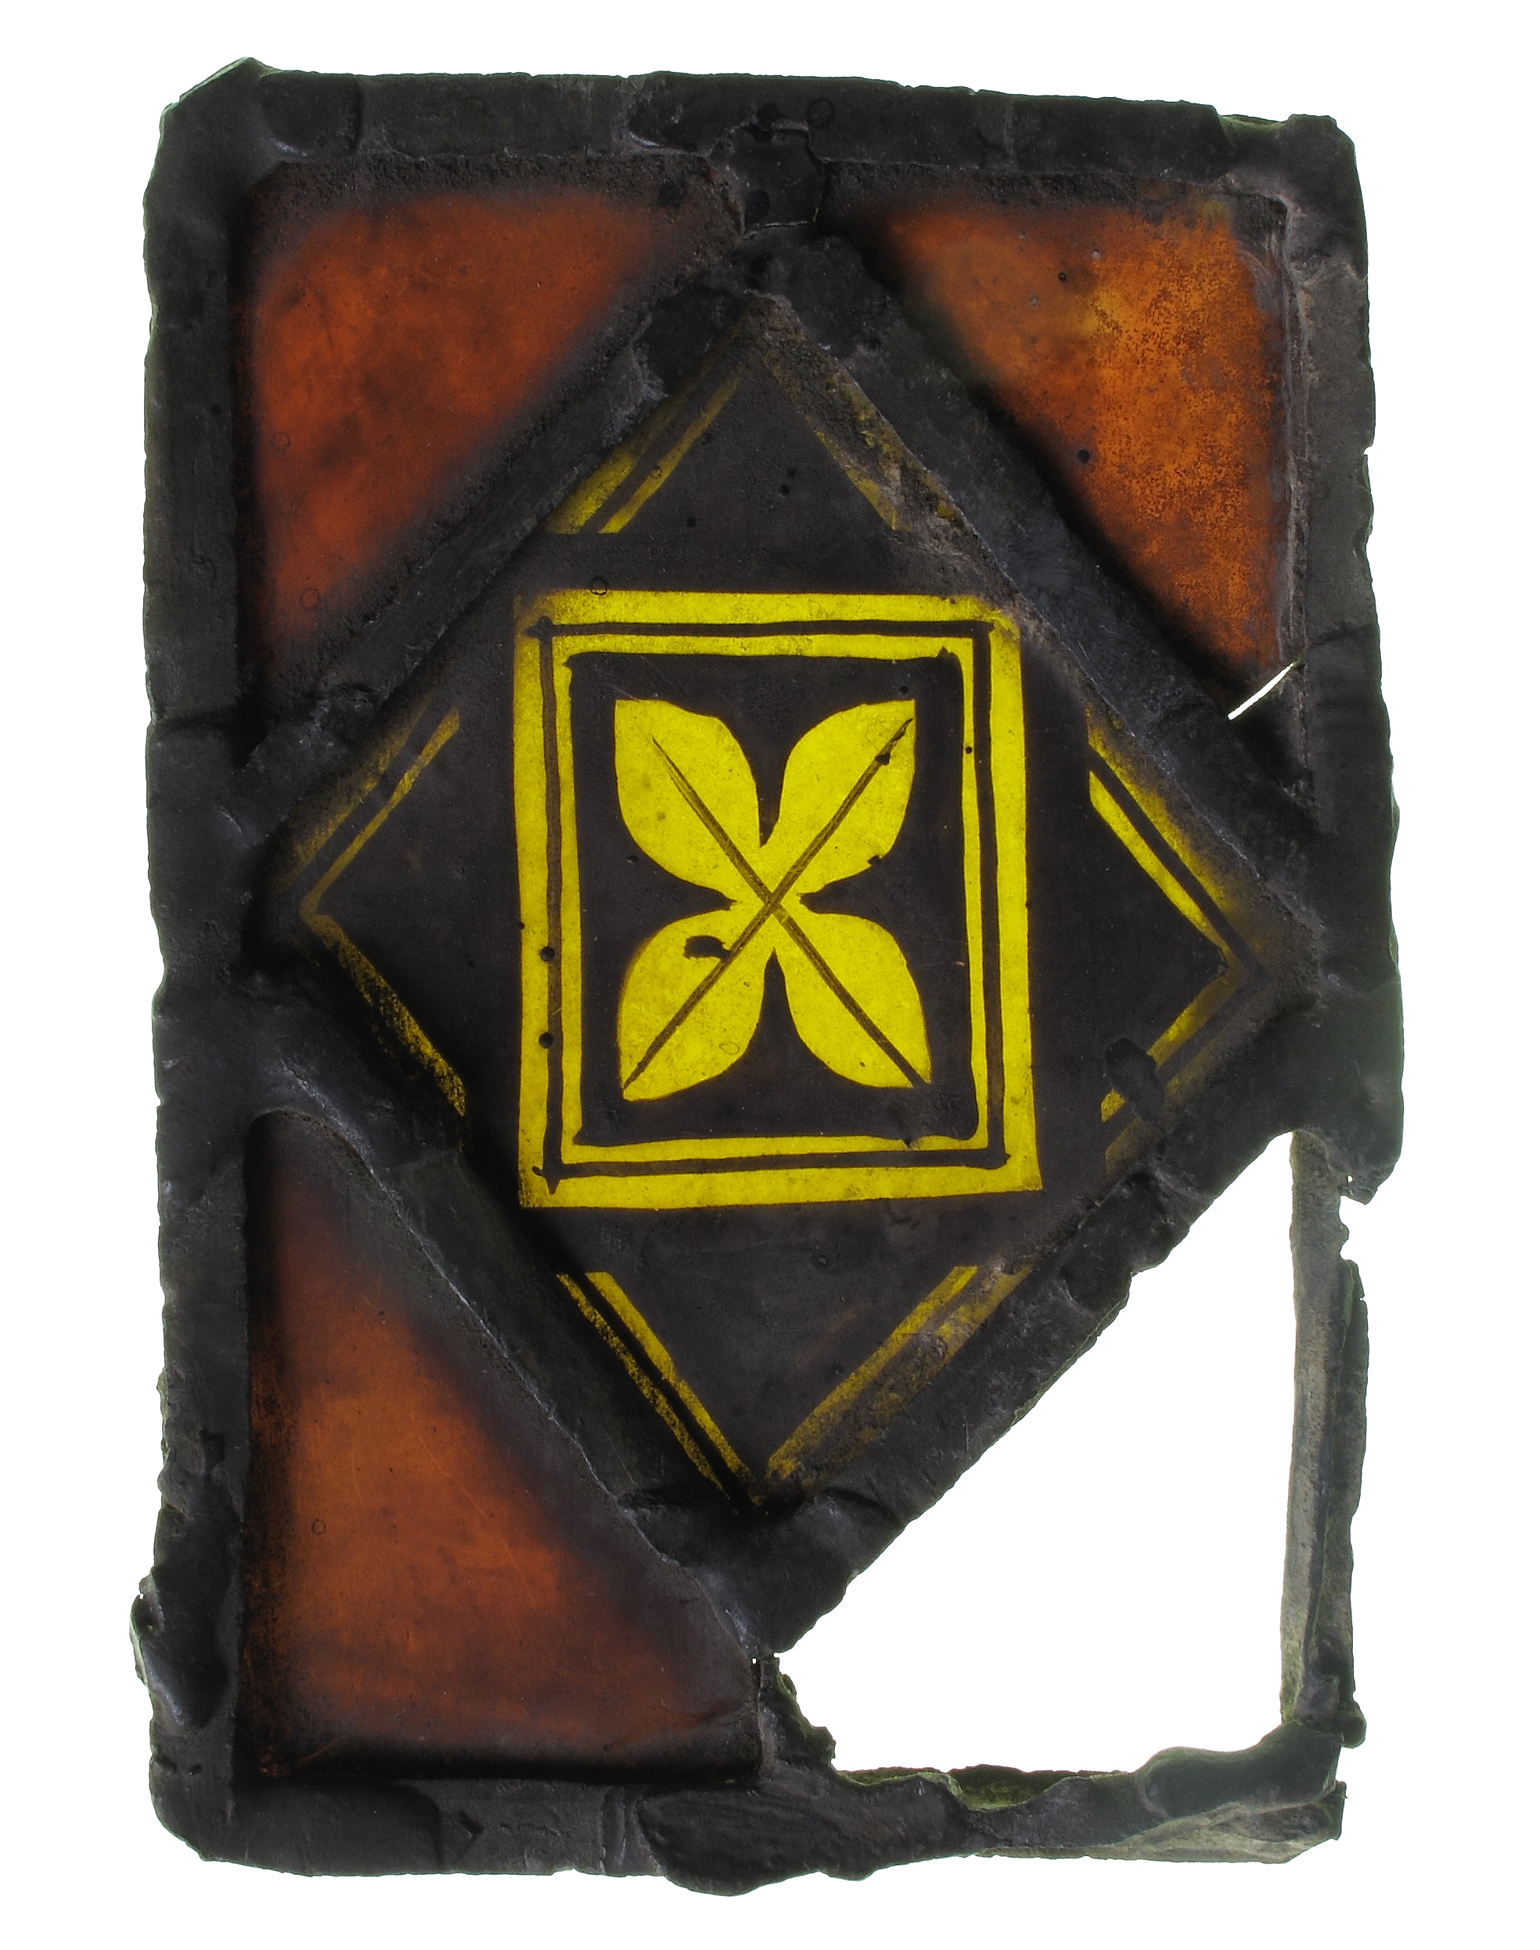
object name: fragment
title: Glass Fragment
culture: french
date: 1201-1300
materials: glass, lead